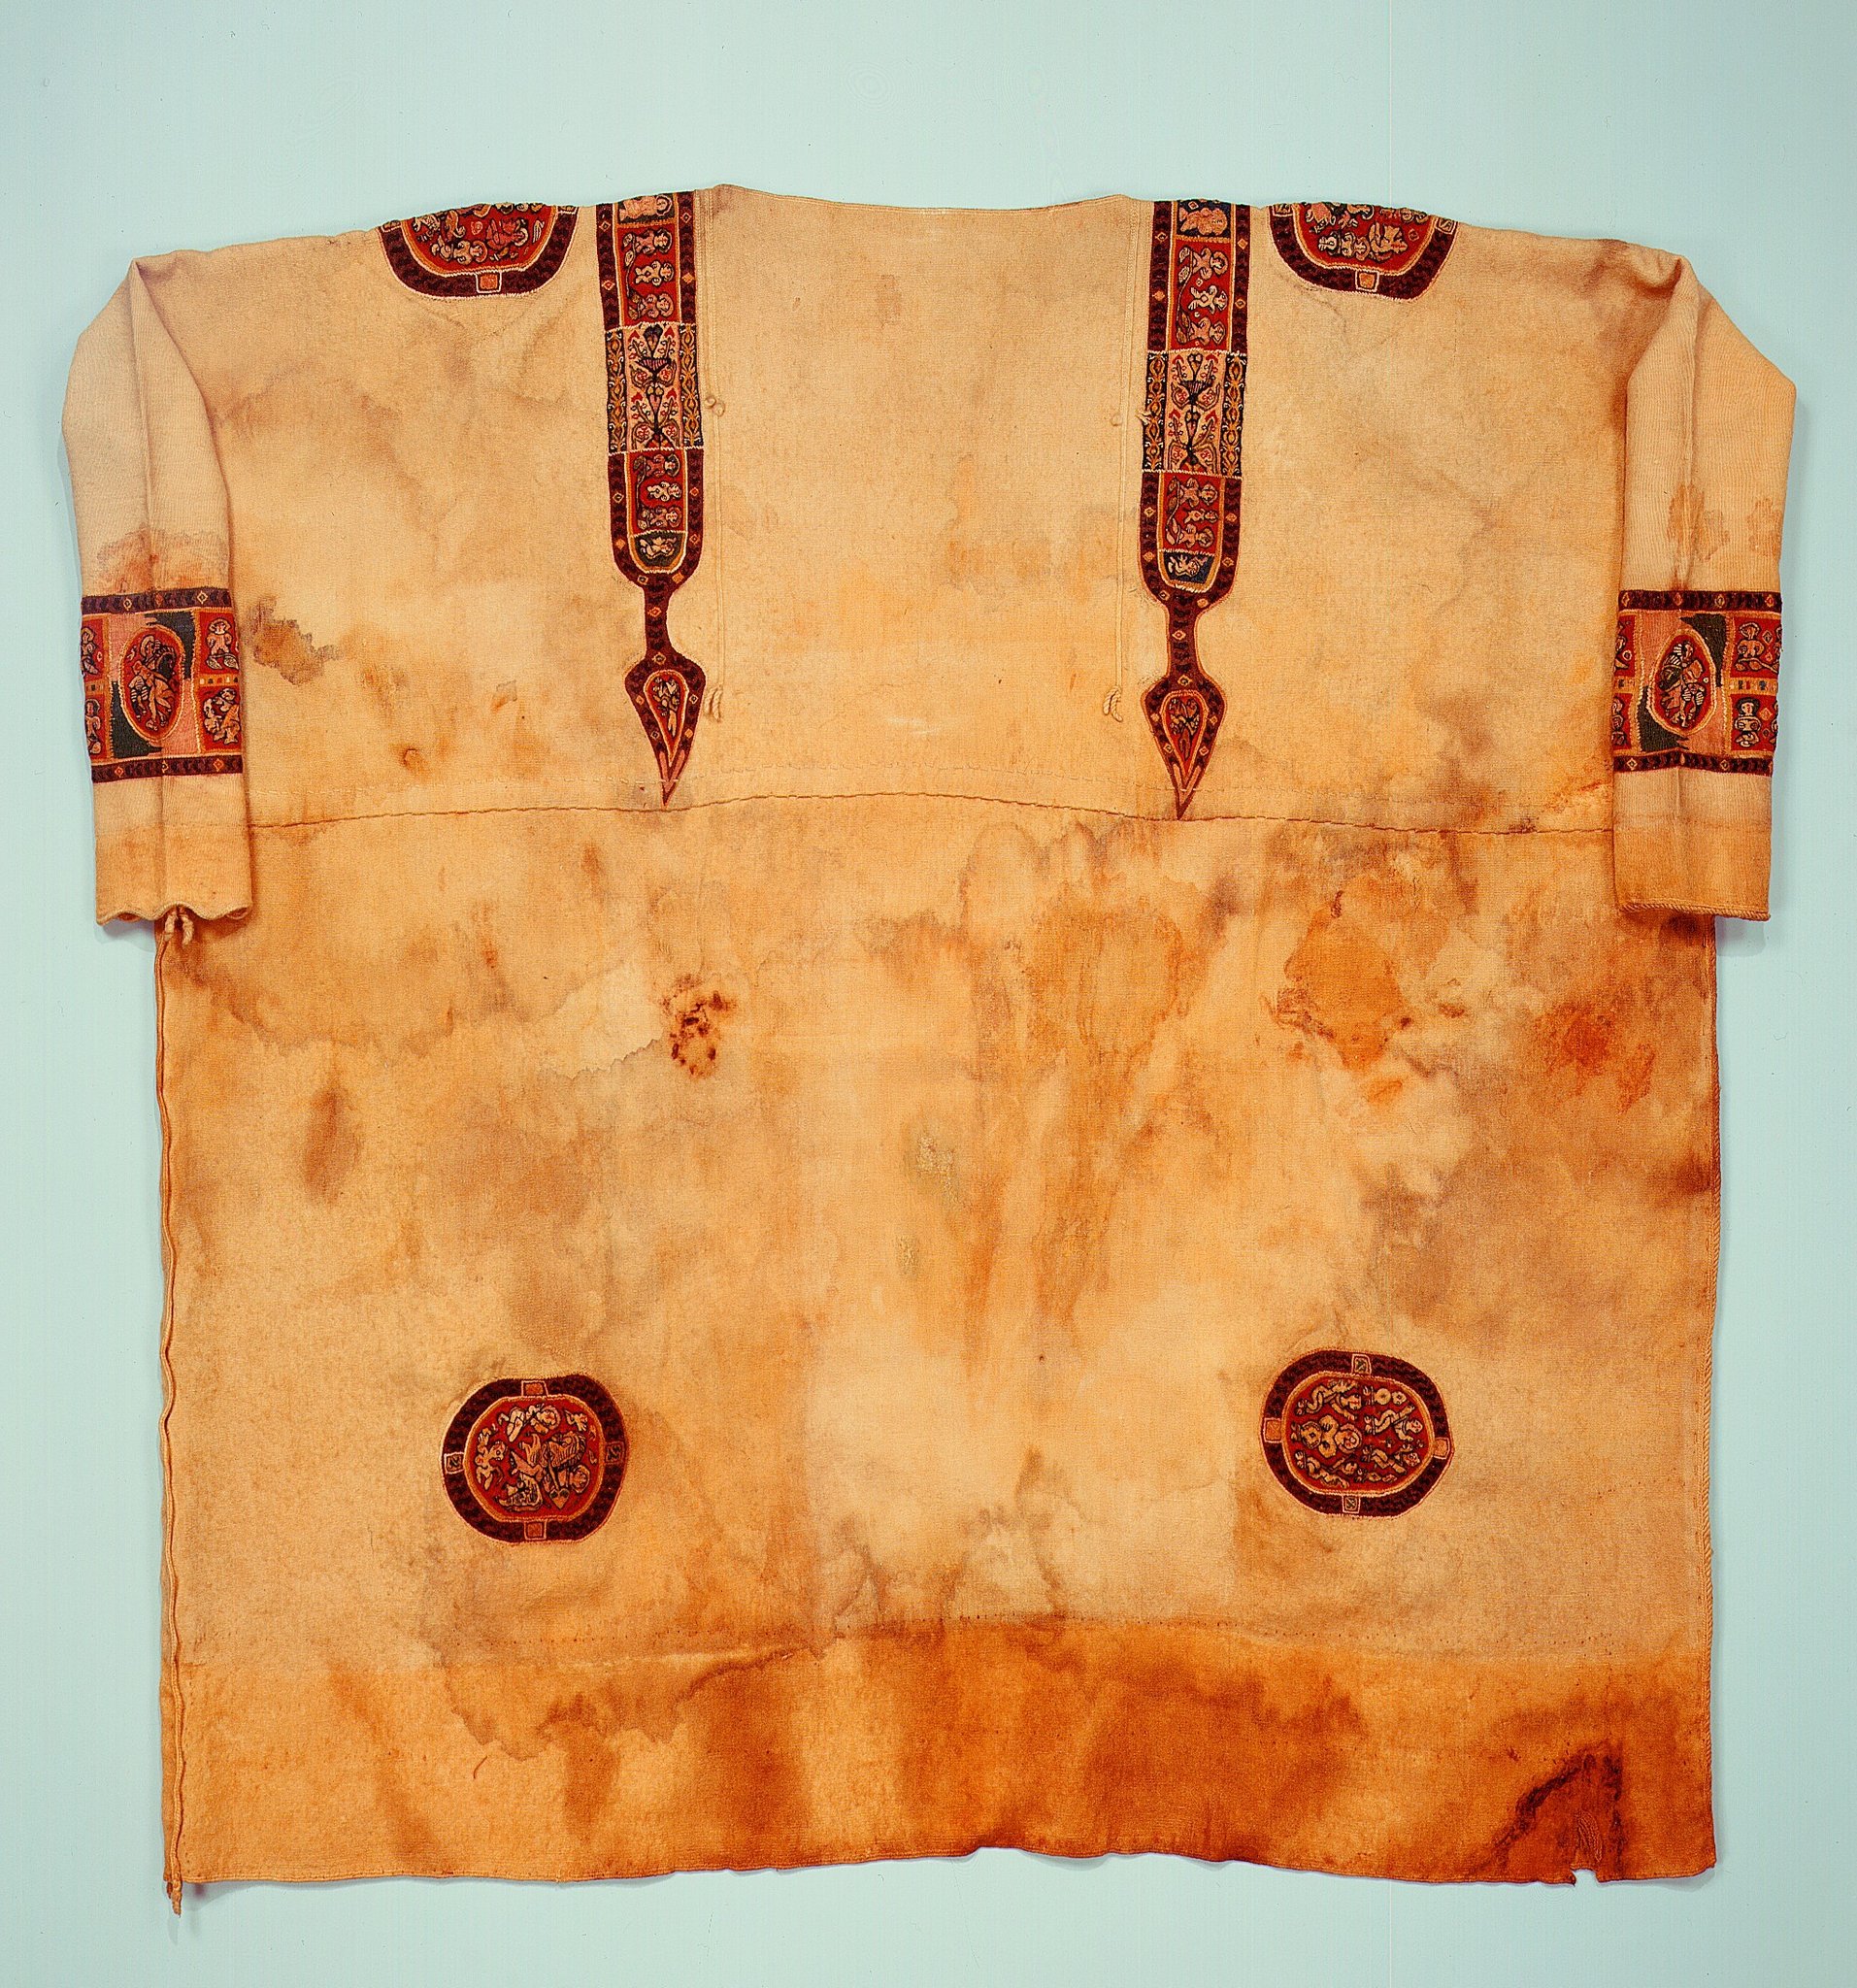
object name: tunic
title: Richly Decorated Tunic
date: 660-870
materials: wool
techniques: weave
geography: egypt